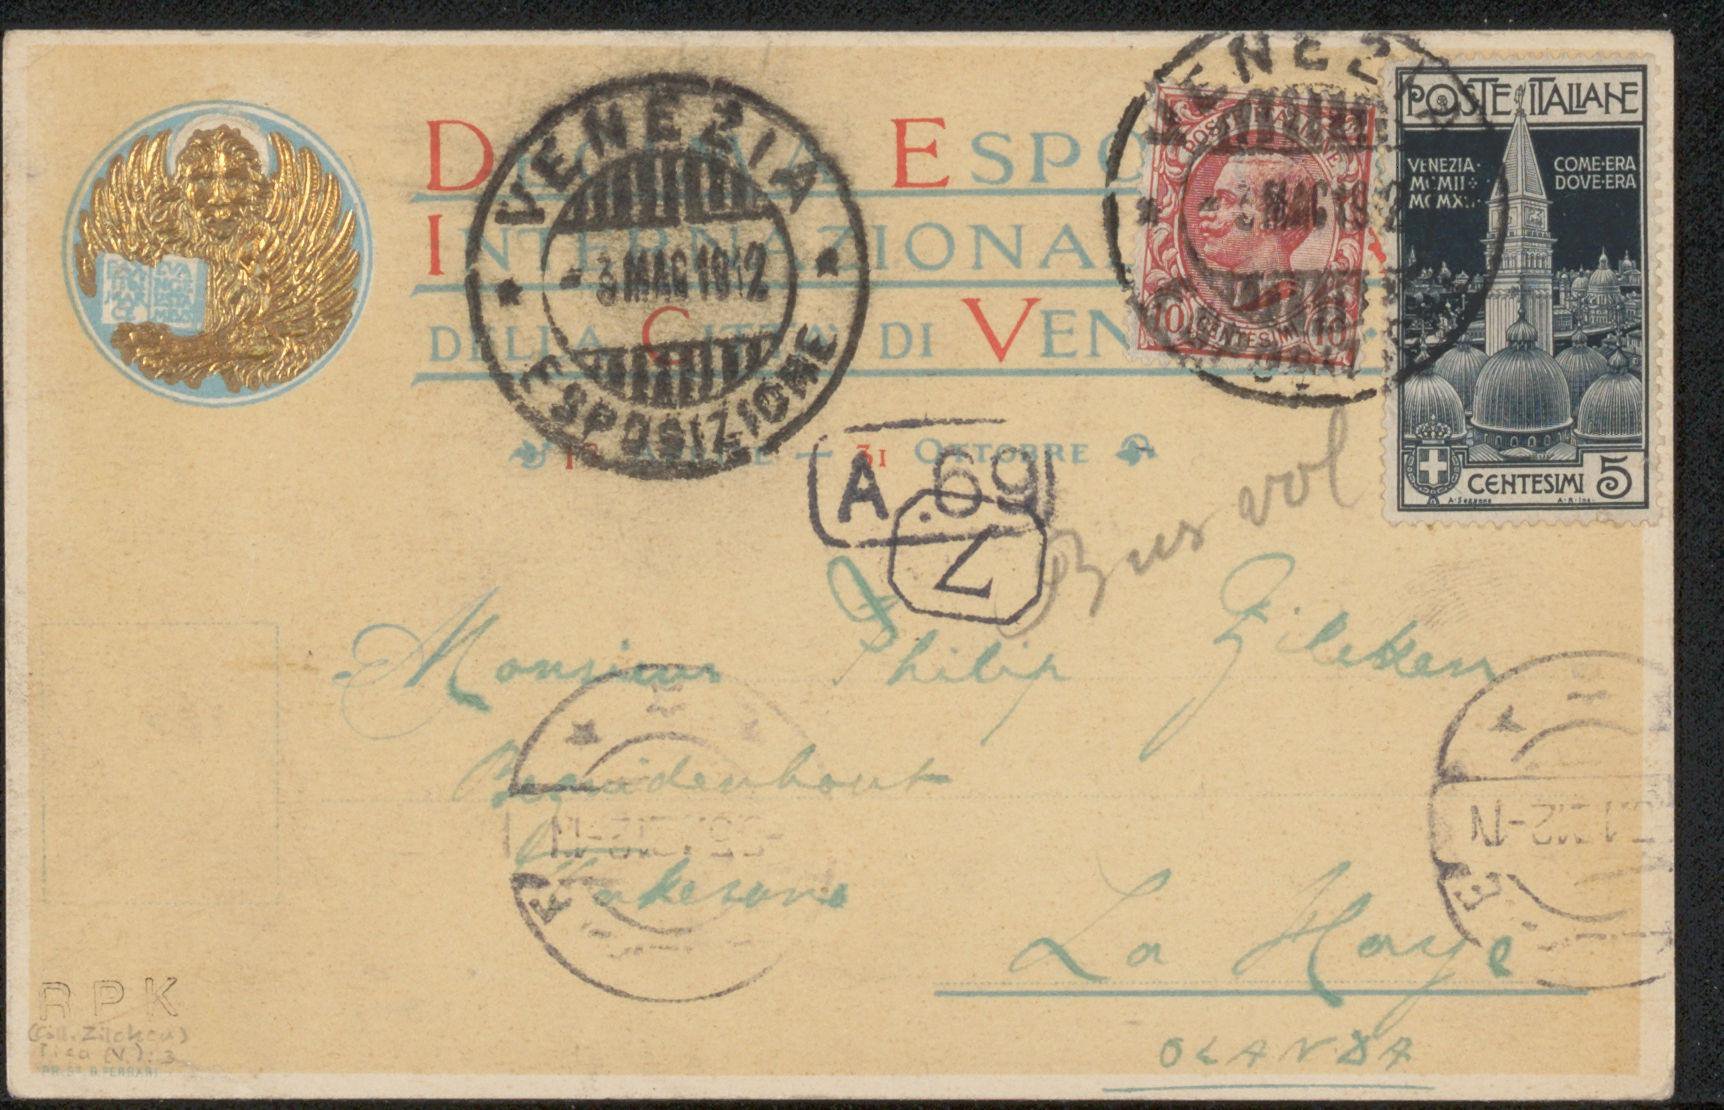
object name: postcard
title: Briefkaart aan Philip Zilcken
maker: vittorio pica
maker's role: criticus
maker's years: 1864-1930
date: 1912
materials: cardboard, ink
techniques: pen, writing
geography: venice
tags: the hague, painter, draughtsman, philip zilcken, exhibition ~ art, venice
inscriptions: collector's mark: ‘RPK’